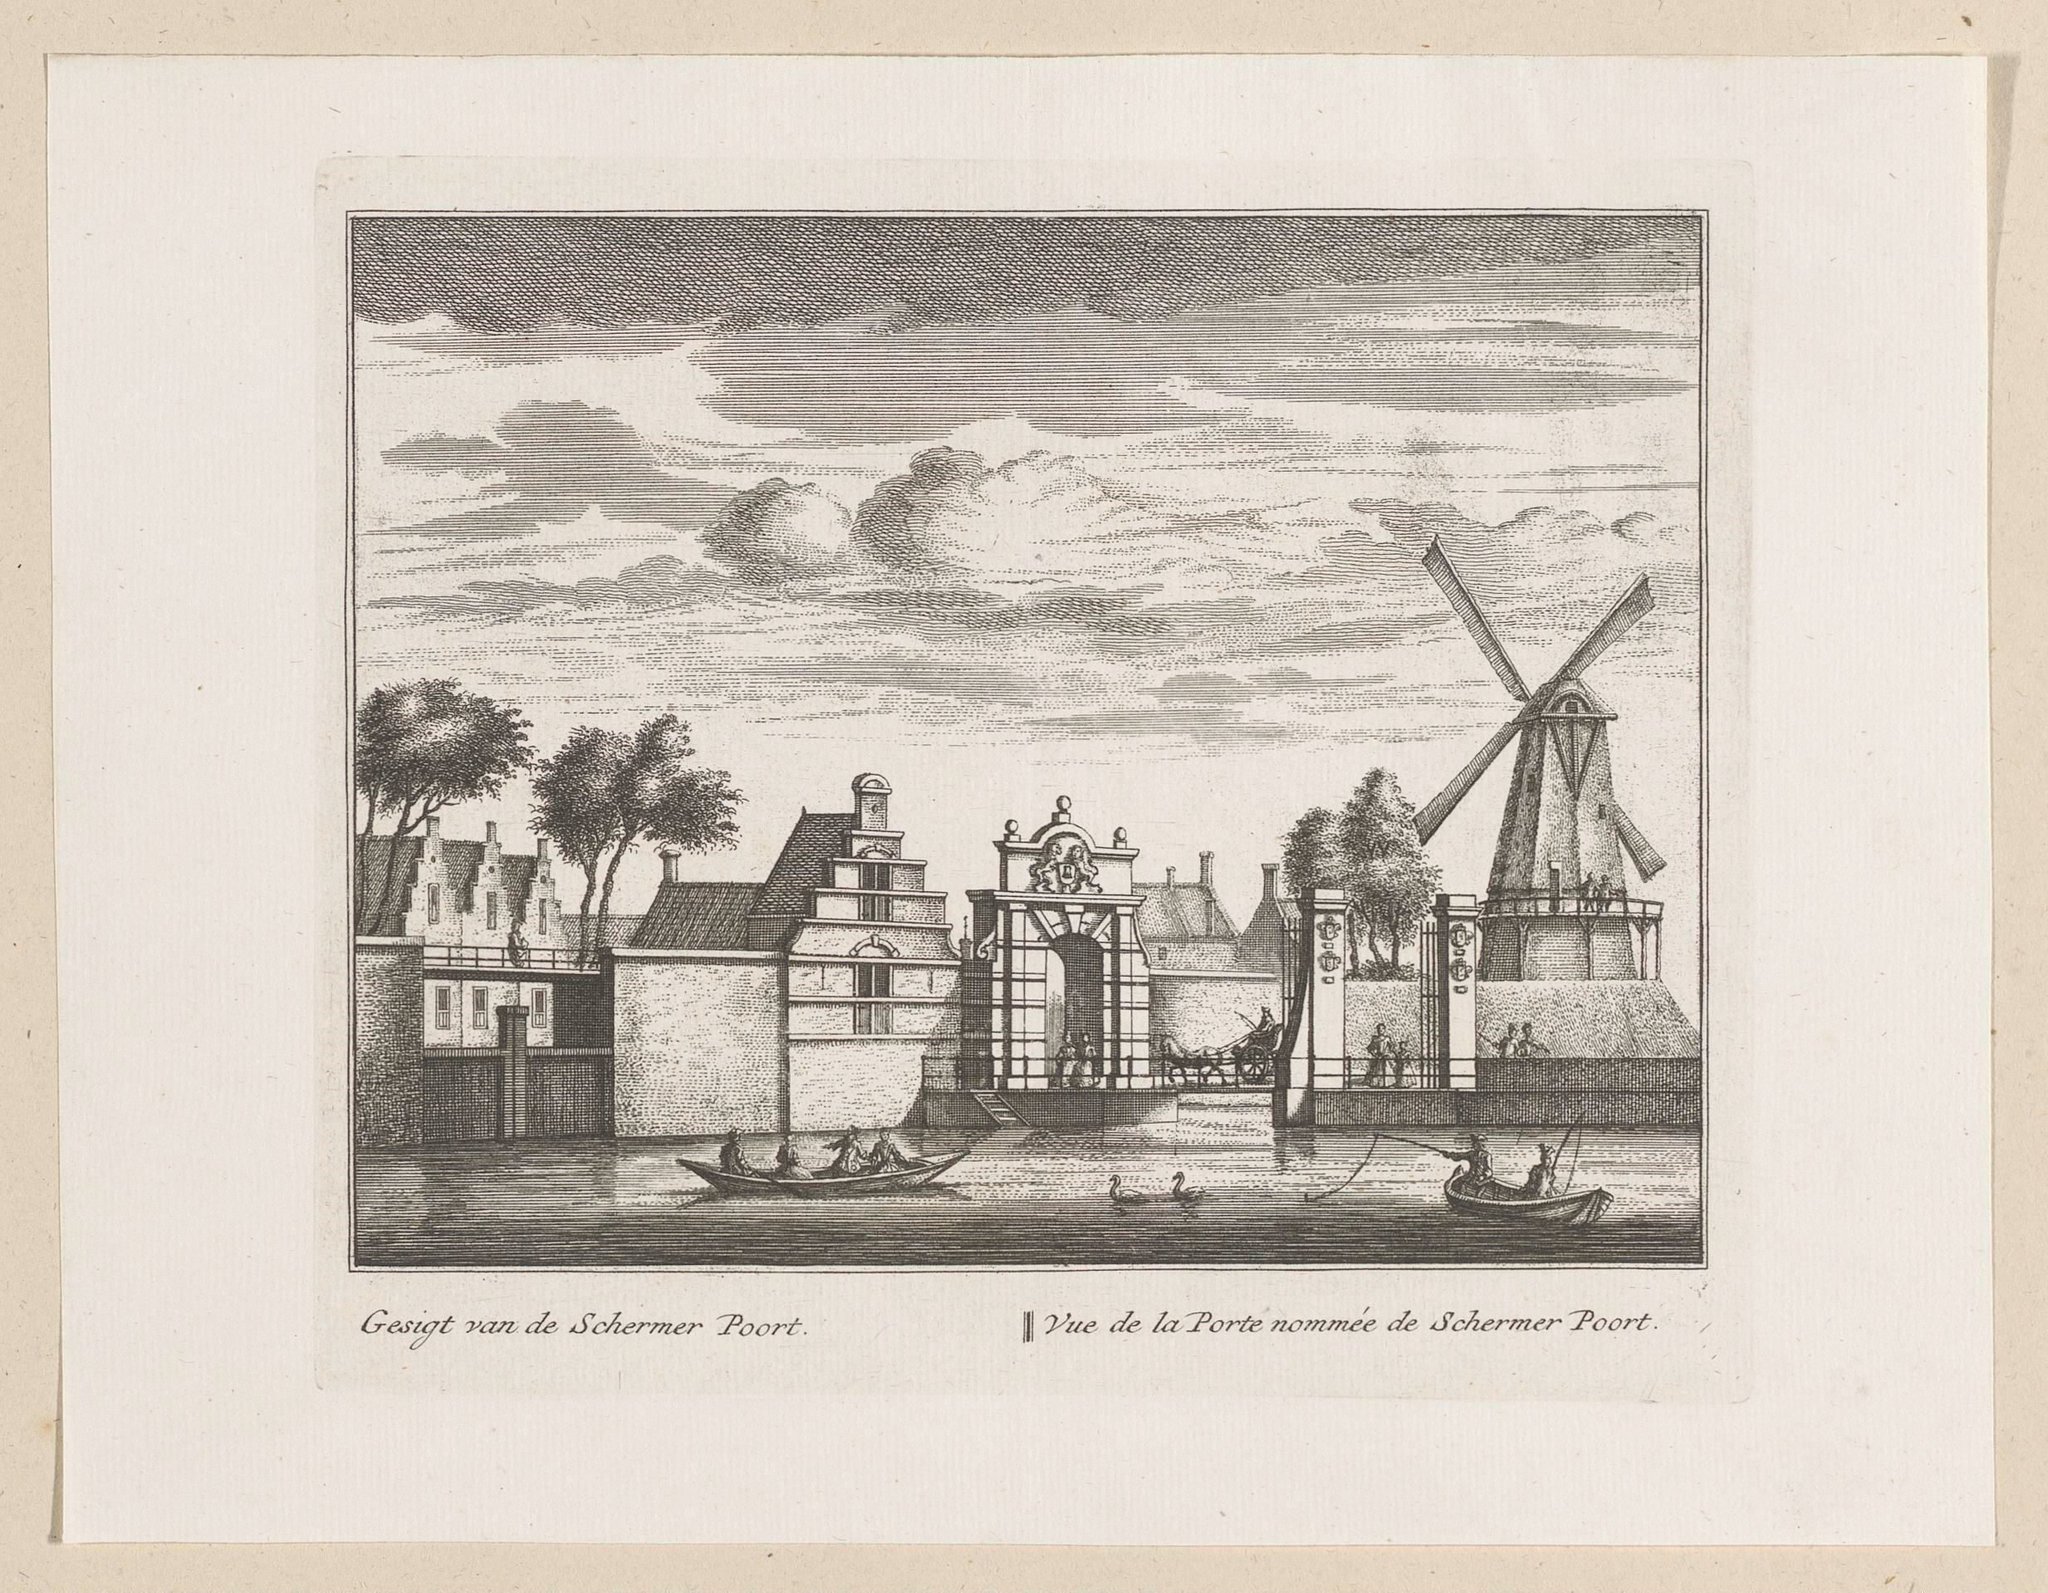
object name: print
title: Alle de voornaamste gesigten van de stadt Alckmaar geleegen in West-Vriesland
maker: leonard schenk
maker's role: print maker, publisher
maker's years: 1696-1767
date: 1736-1746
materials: paper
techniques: etching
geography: amsterdam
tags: rowing-boat, canoe, etc., bridge, windmill, city-gate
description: Als onderdeel van een prentserie van gezichten op Alkmaar in een publicatie met drie prentseries van stadsgezichten (op Alkmaar, Delft en Dordrecht) is deze prent ook gebruikt in: Rademaker, Abraham. Alle de voornaamste gesigten van de wydberoemde steeden Alkmaar, Delft en Dordregt (...) / Toutes les principales vuës de la fameuse villes d'Alcmar, Delft & Dordregt (…). Amsterdam: Leonard Schenk, 1736. Als illustratie is deze prent ook gebruikt in: Woude, C. van der. Kronyck van Alckmaar. Met zyn dorpen (…). 2e druk. Amsterdam: Steven van Esveldt, 1743. En in: Woude, C. van der. Kronyck van Alckmaar. Met zyn dorpen (…). 2e druk. Den Haag: Johannes de Cros, 1746. Uit welke druk het huidige exemplaar precies komt is niet na te gaan.